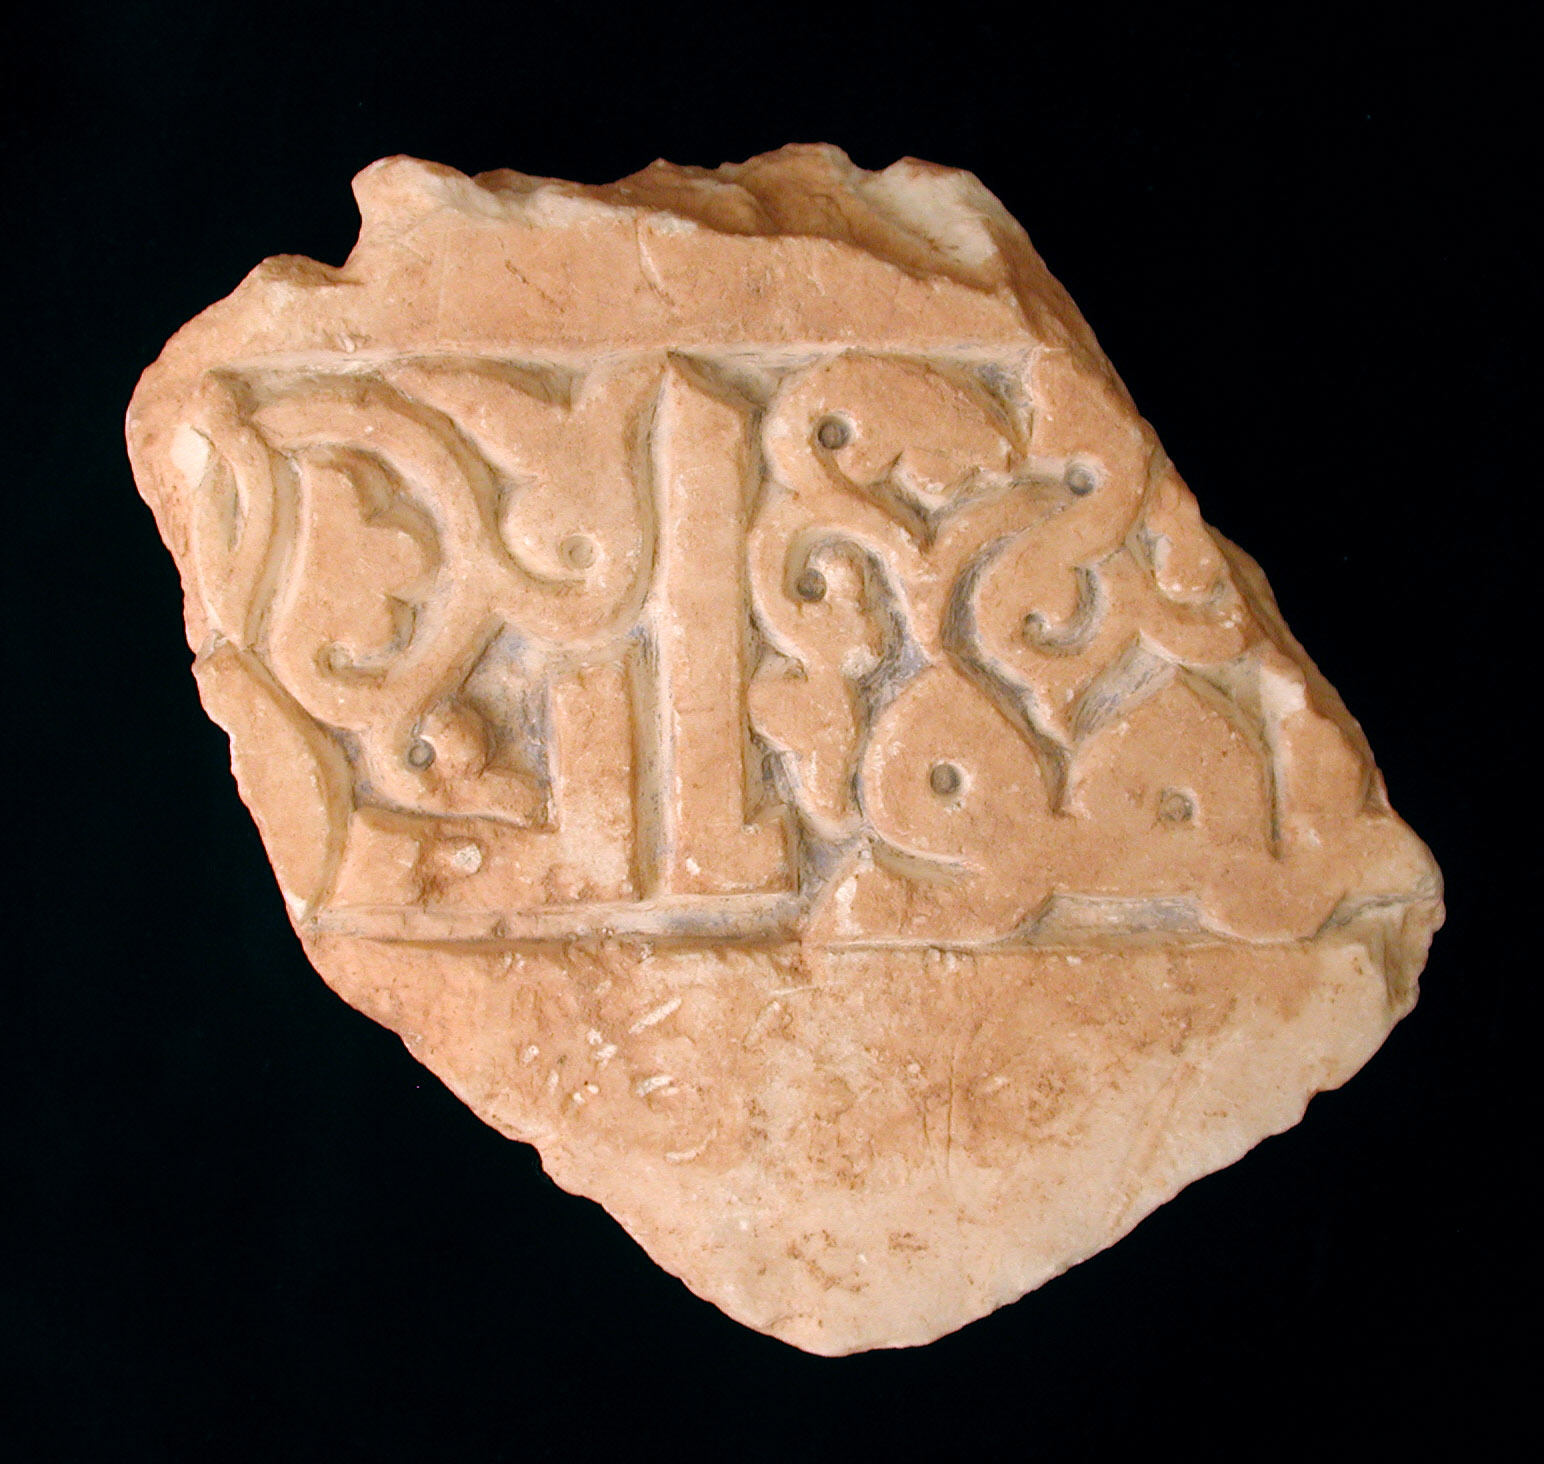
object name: fragment of a dado panel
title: Fragment of a Carved and Painted Dado Panel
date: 901-1100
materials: stone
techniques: carving, painting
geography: iran